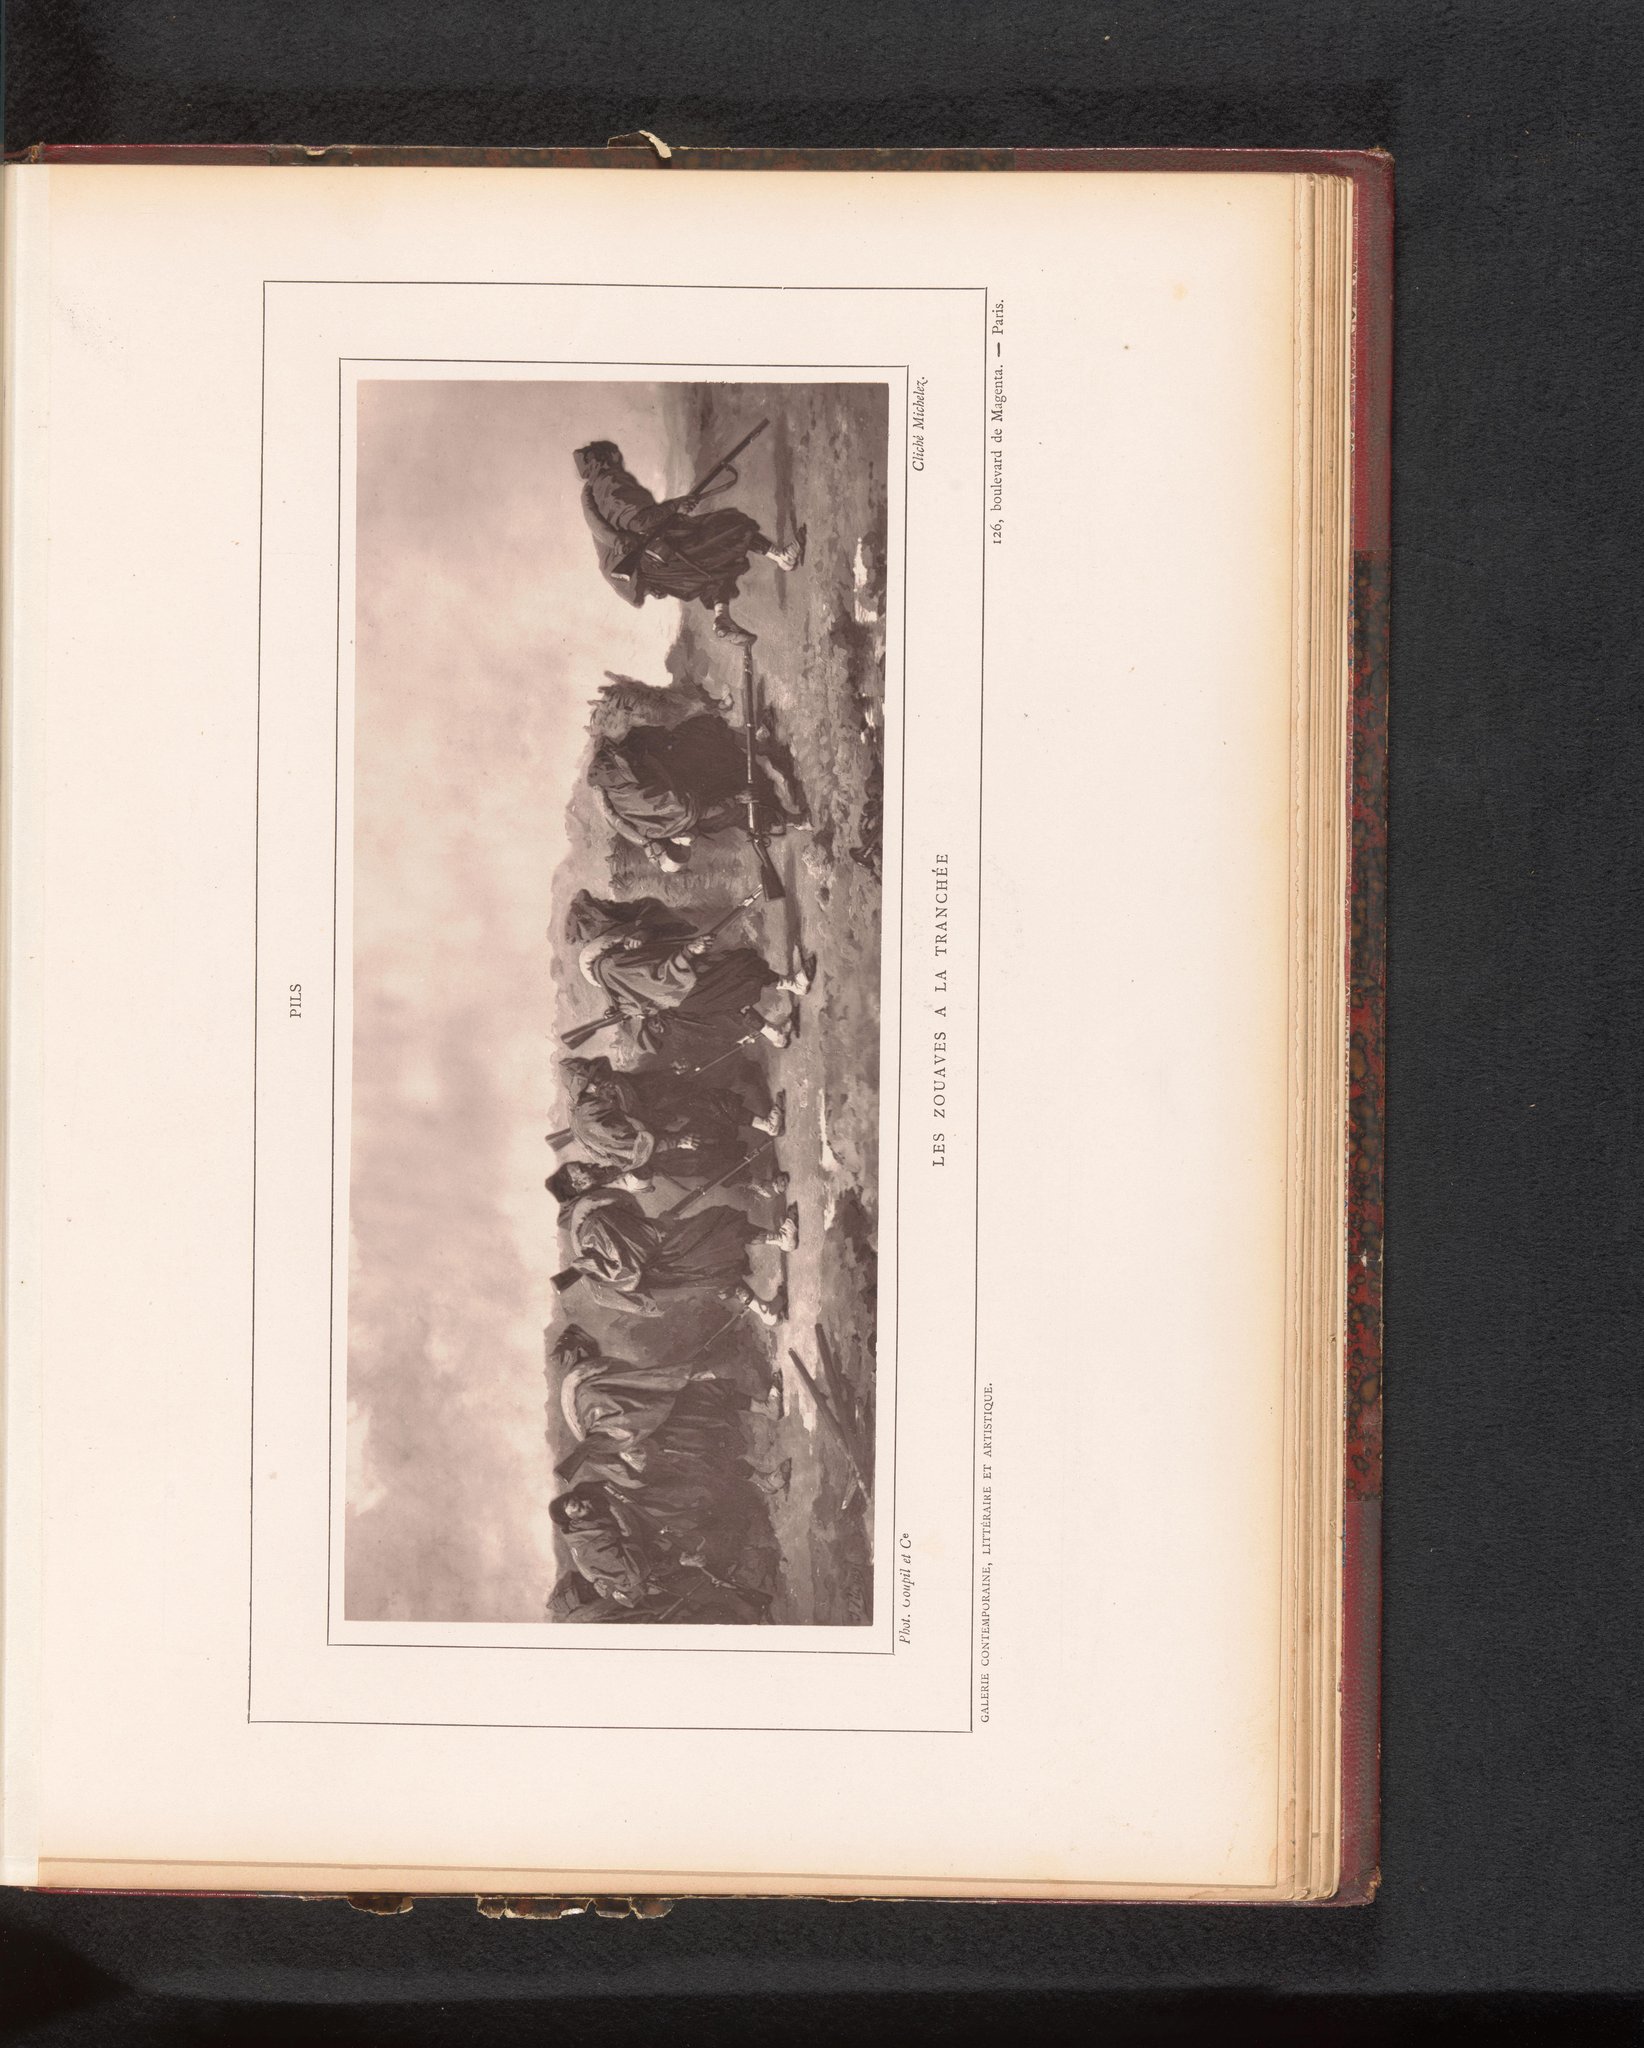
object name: page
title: Reproductie van Les zouaves a la tranchée door Isidore Pils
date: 1871-1877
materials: paper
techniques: woodburytype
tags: the soldier; the soldier's life, painting, drawing and the graphic arts, trenches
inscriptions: inscription: ‘Galerie Contemporaine, Littéraire, Artistique/ 126, boulevard de Magenta, Paris’